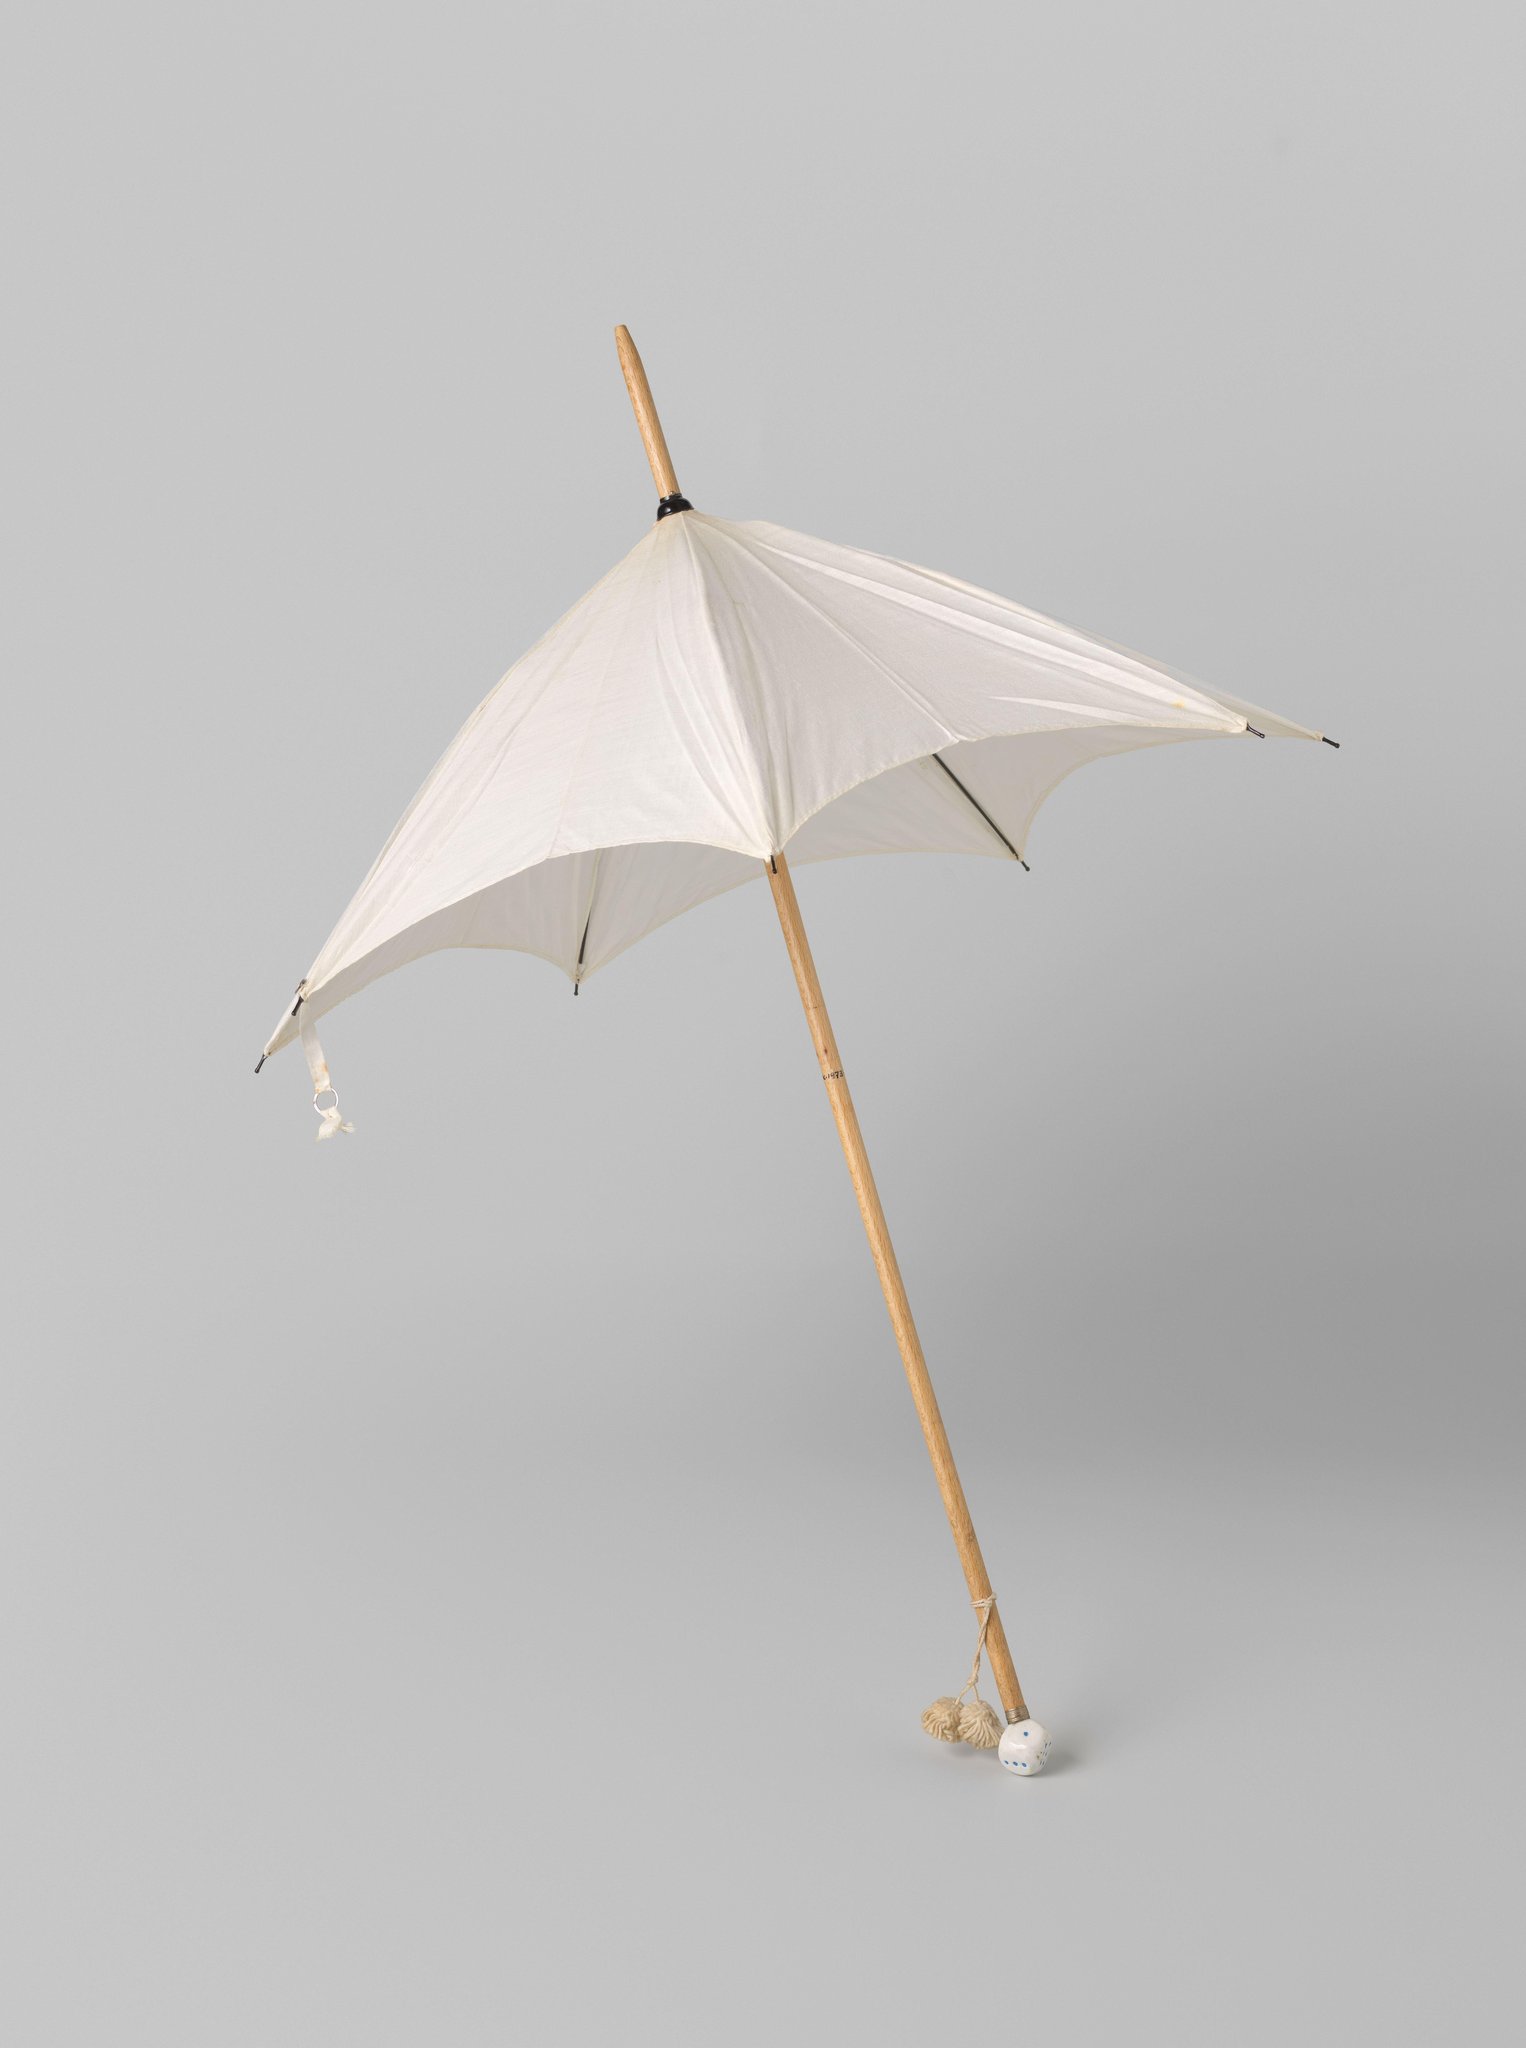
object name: parasol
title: Parasol met dek van effen witte katoen, op een smalle houten stok, met onderaan een witte dobbelsteen waarop blauwe stippen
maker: gustav schnitzler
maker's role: paraplufabrikant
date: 1900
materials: ceramic, cotton, iron, wood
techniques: casting, cutting, firing, vitrification, weave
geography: nijmegen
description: Parasol met dek van effen witte katoen. Ongevoerd, met zeven zwarte ijzeren baleinen. Smalle onversierde houten stok, met onderaan een witte dobbelsteen waarop blauwe stippen. Bovenop een langwerpige houten punt.